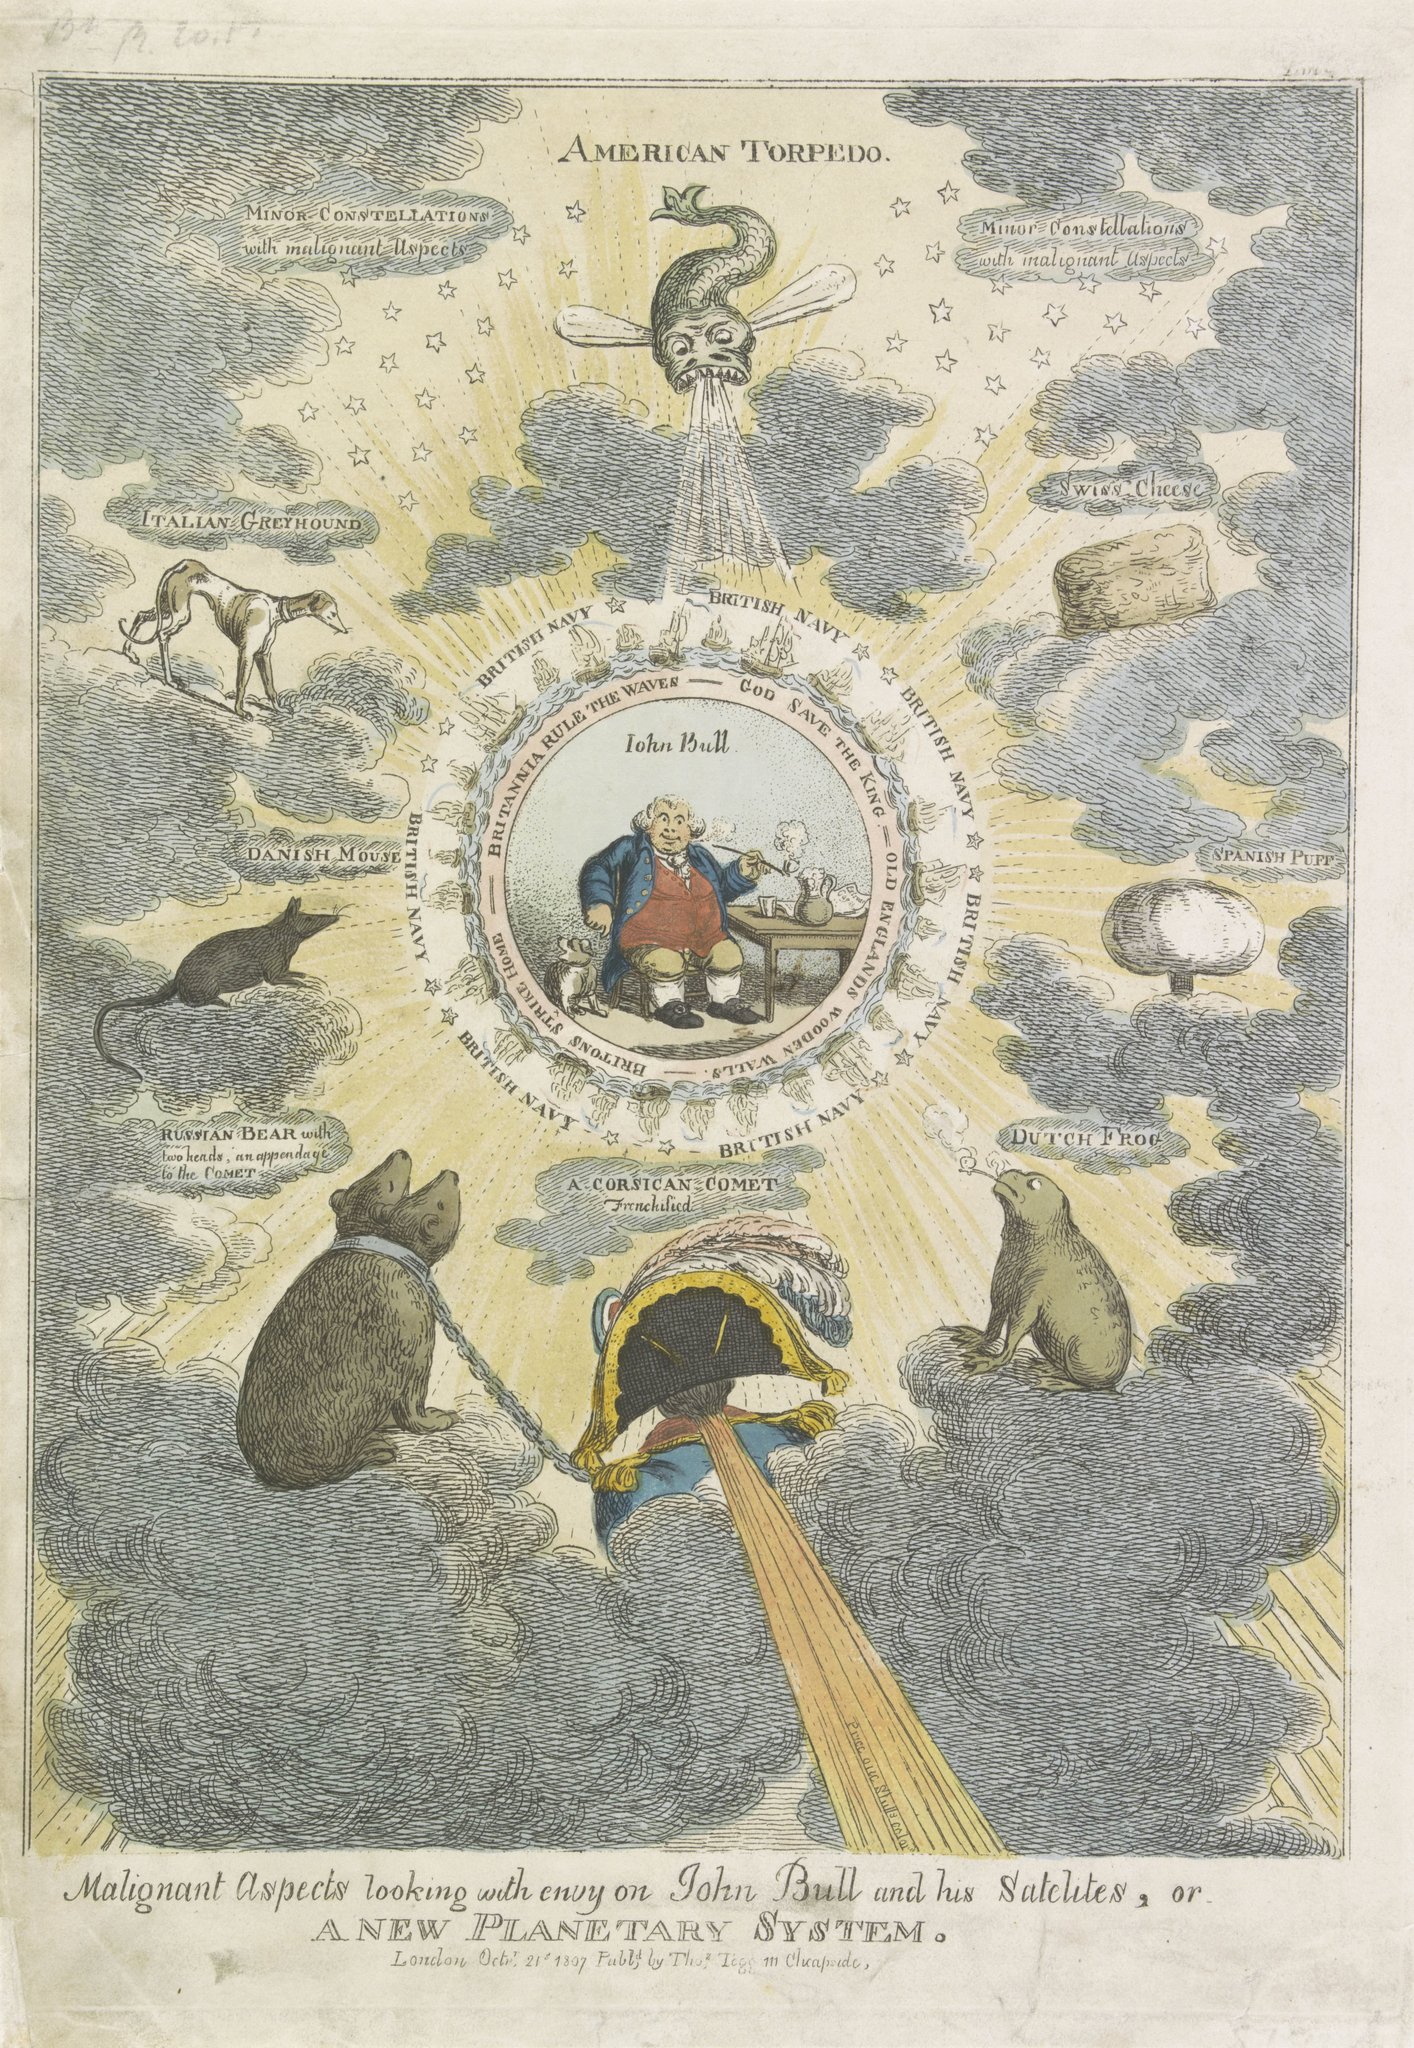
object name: print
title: Malignant aspects looking with envy on John Bull and his satelites, or a new planetary system.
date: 1807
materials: paper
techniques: etching, hand coloring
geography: london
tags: napoleon i (emperor of the french), personifications of countries, nations, states, districts, etc., comet, cartilaginous fishes: ray, planets; planetary system, solar system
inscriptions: collector's mark: Lugt 2228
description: John Bull (Groot-Brittannië) als een stralende zon, het gelukkige en veilige middelpunt van een vijandig zonnestelsel. Hij wordt omringd door zijn satellieten of planeten: allerlei vijanden waaronder de Corsicaanse komeet (Napoleon), de Amerikaanse sidderrog (Torpedo) en de Hollandse kikvors.